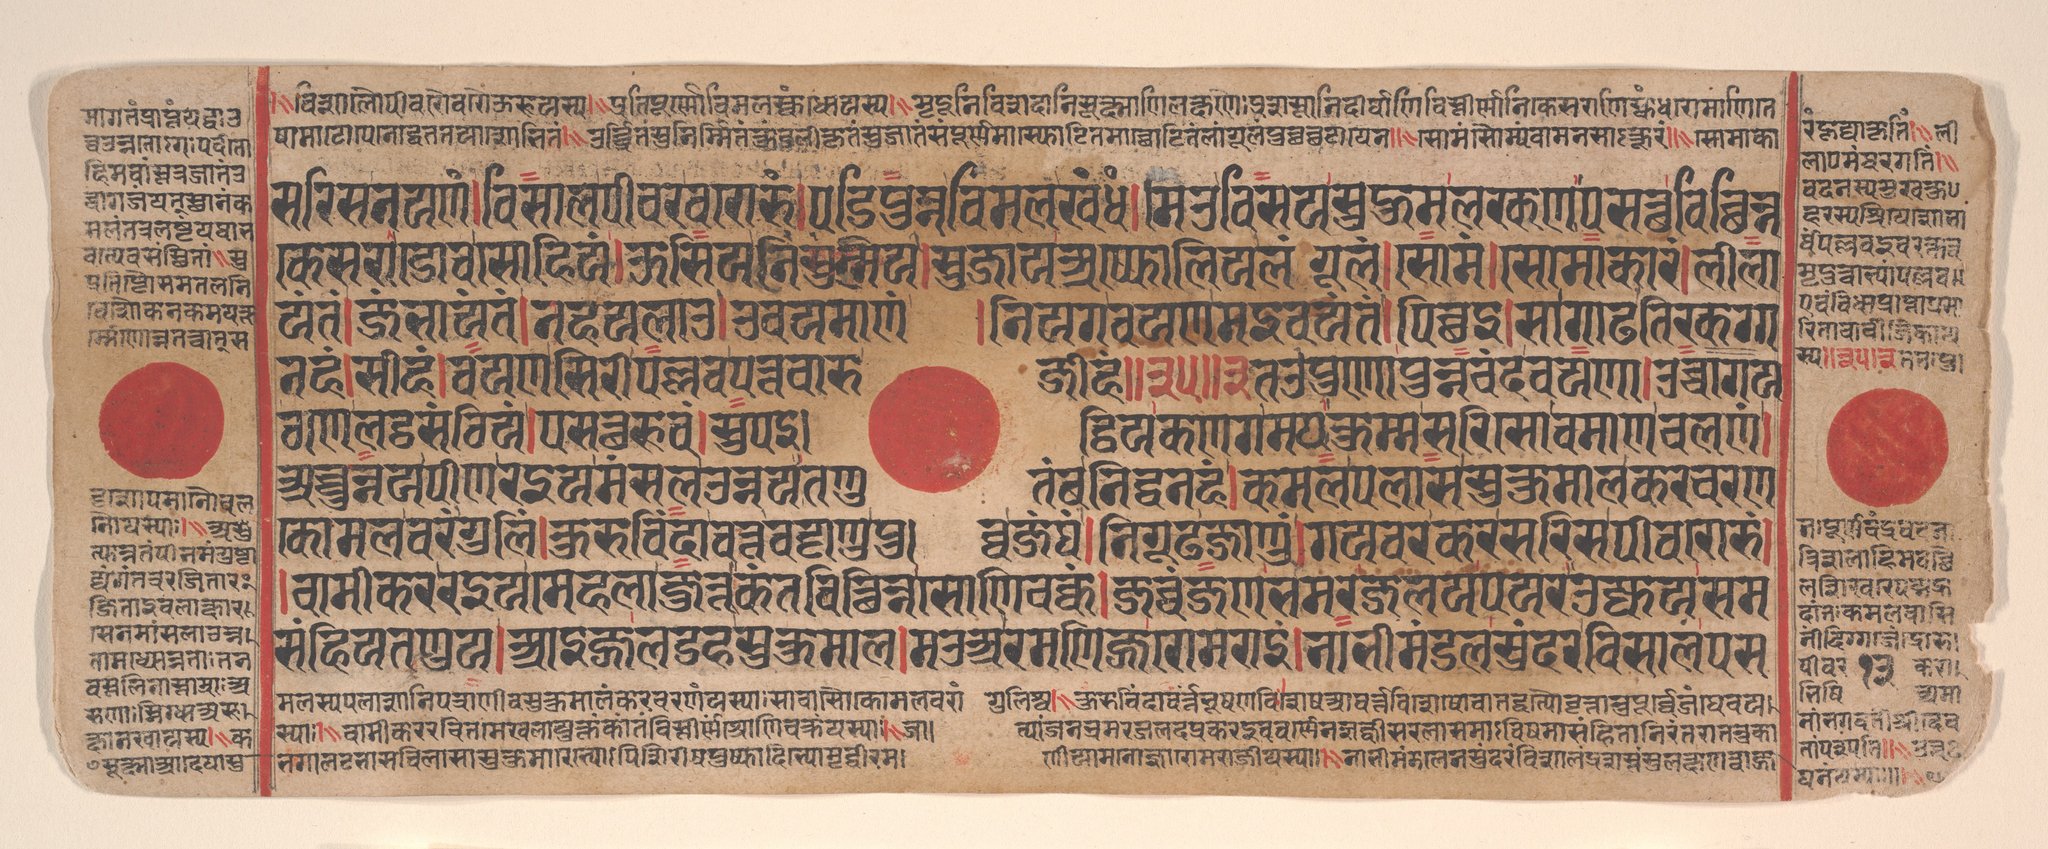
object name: folio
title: Leaf from a Kalpa Sutra (Jain Book of Rituals)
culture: indian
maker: bhadrabahu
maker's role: artist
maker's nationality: indian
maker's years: 356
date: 1401-1500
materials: gold, ink, paper, watercolor